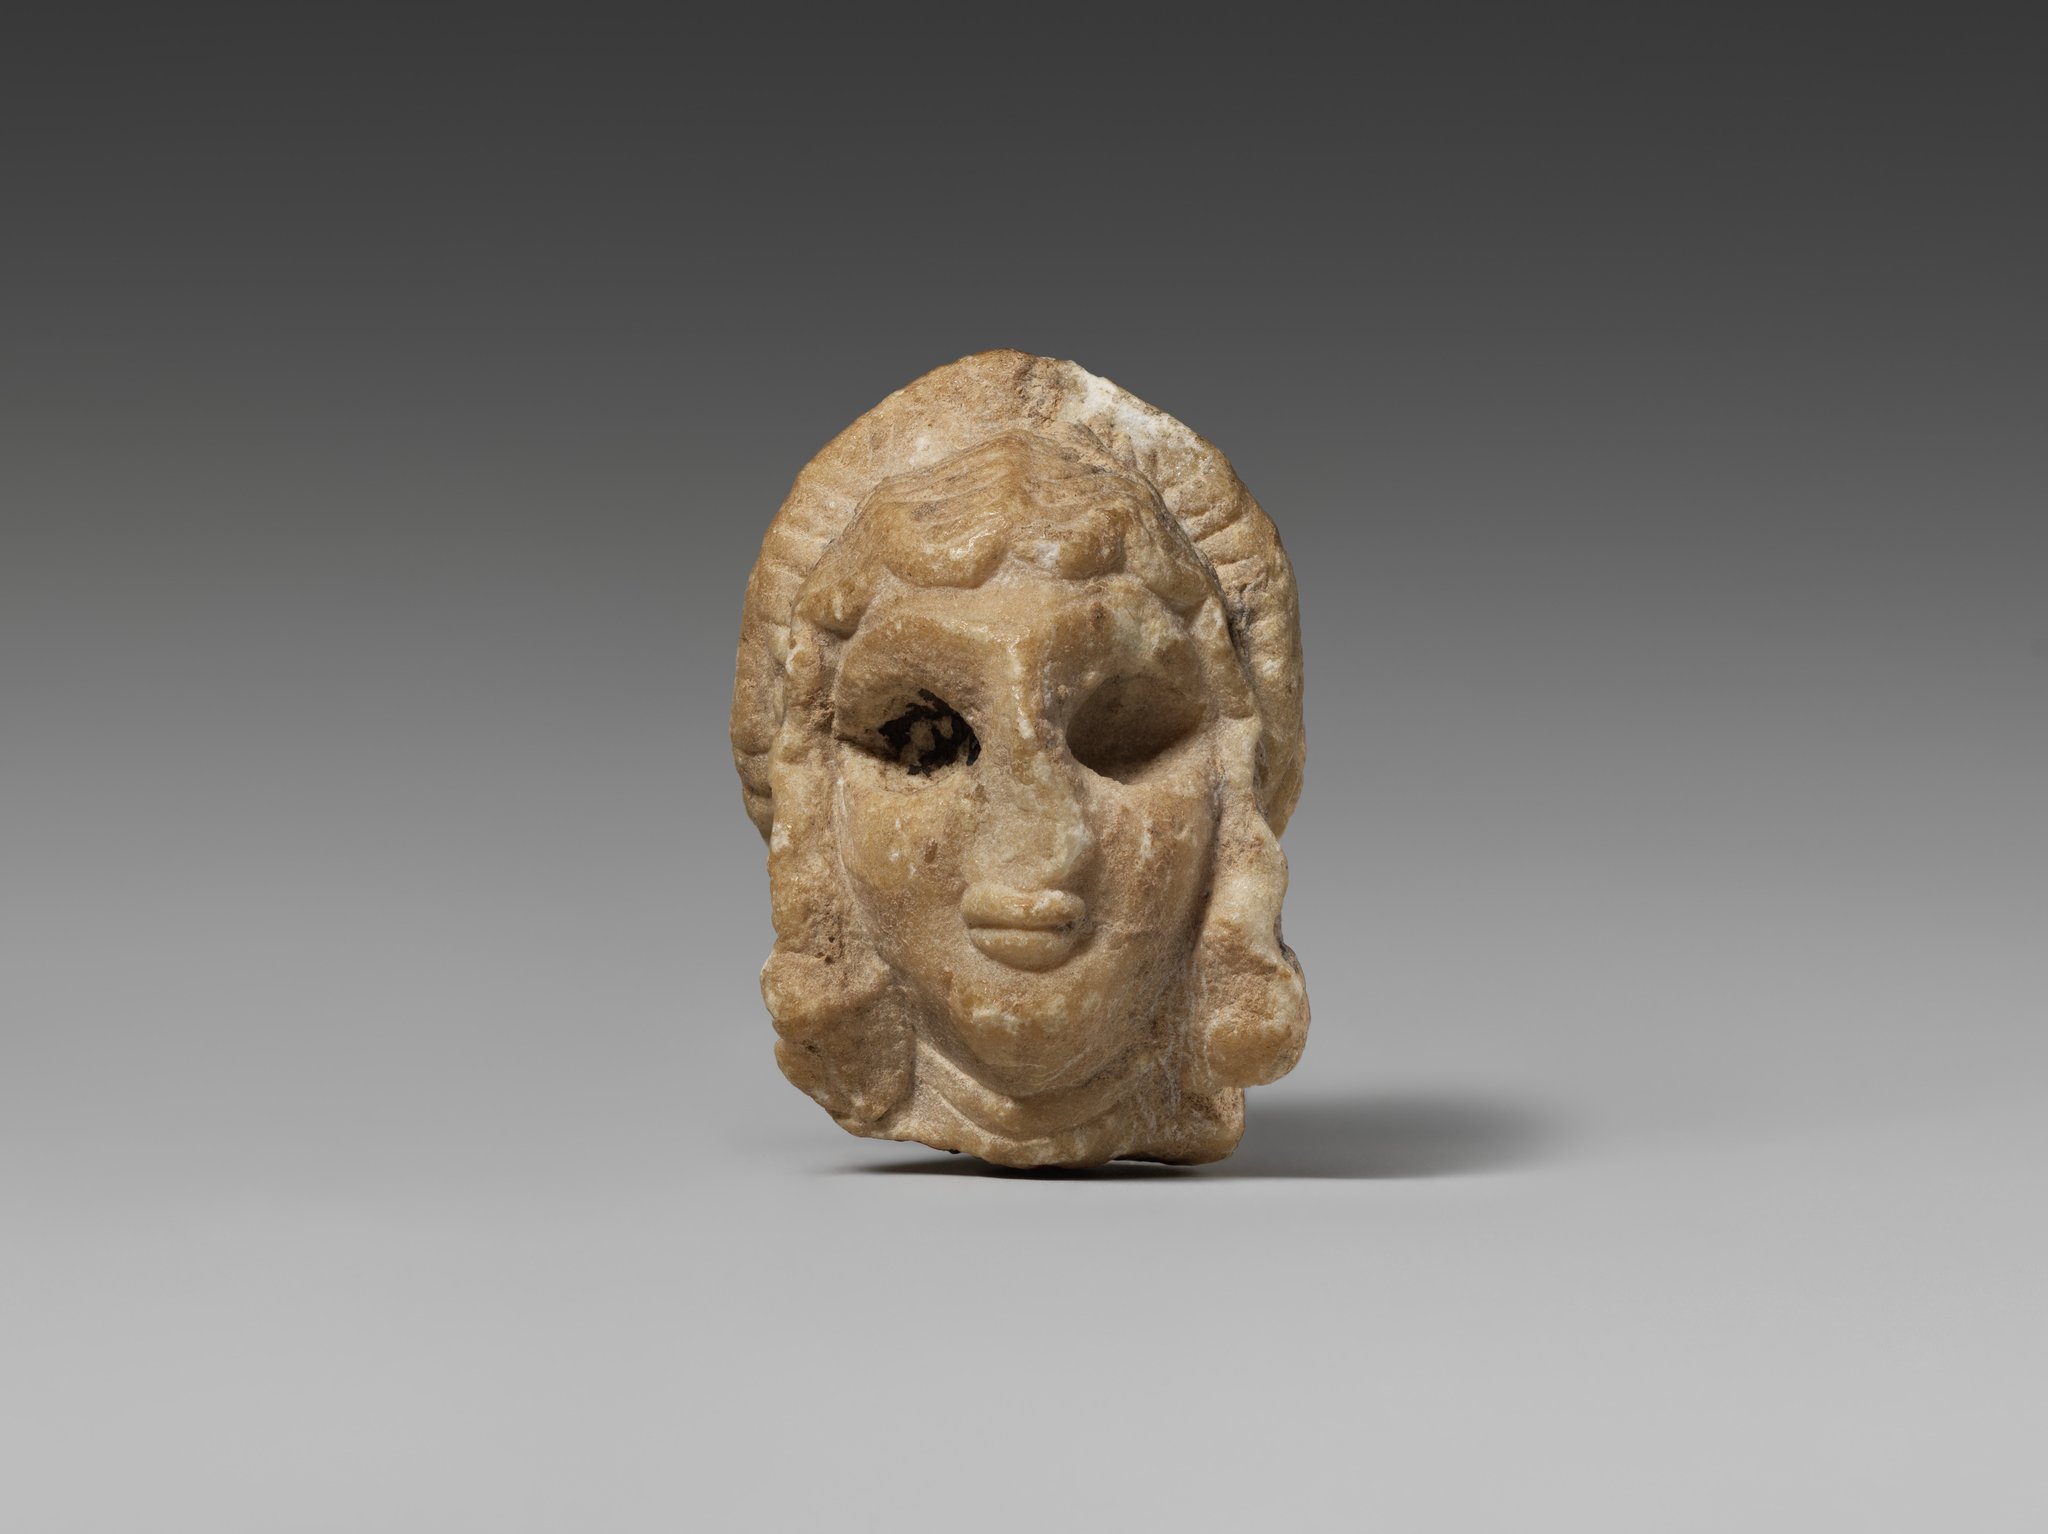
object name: sculpture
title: Female head with elaborate hairstyle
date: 2600-2500 BCE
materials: alabaster, gypsum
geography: mesopotamia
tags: women